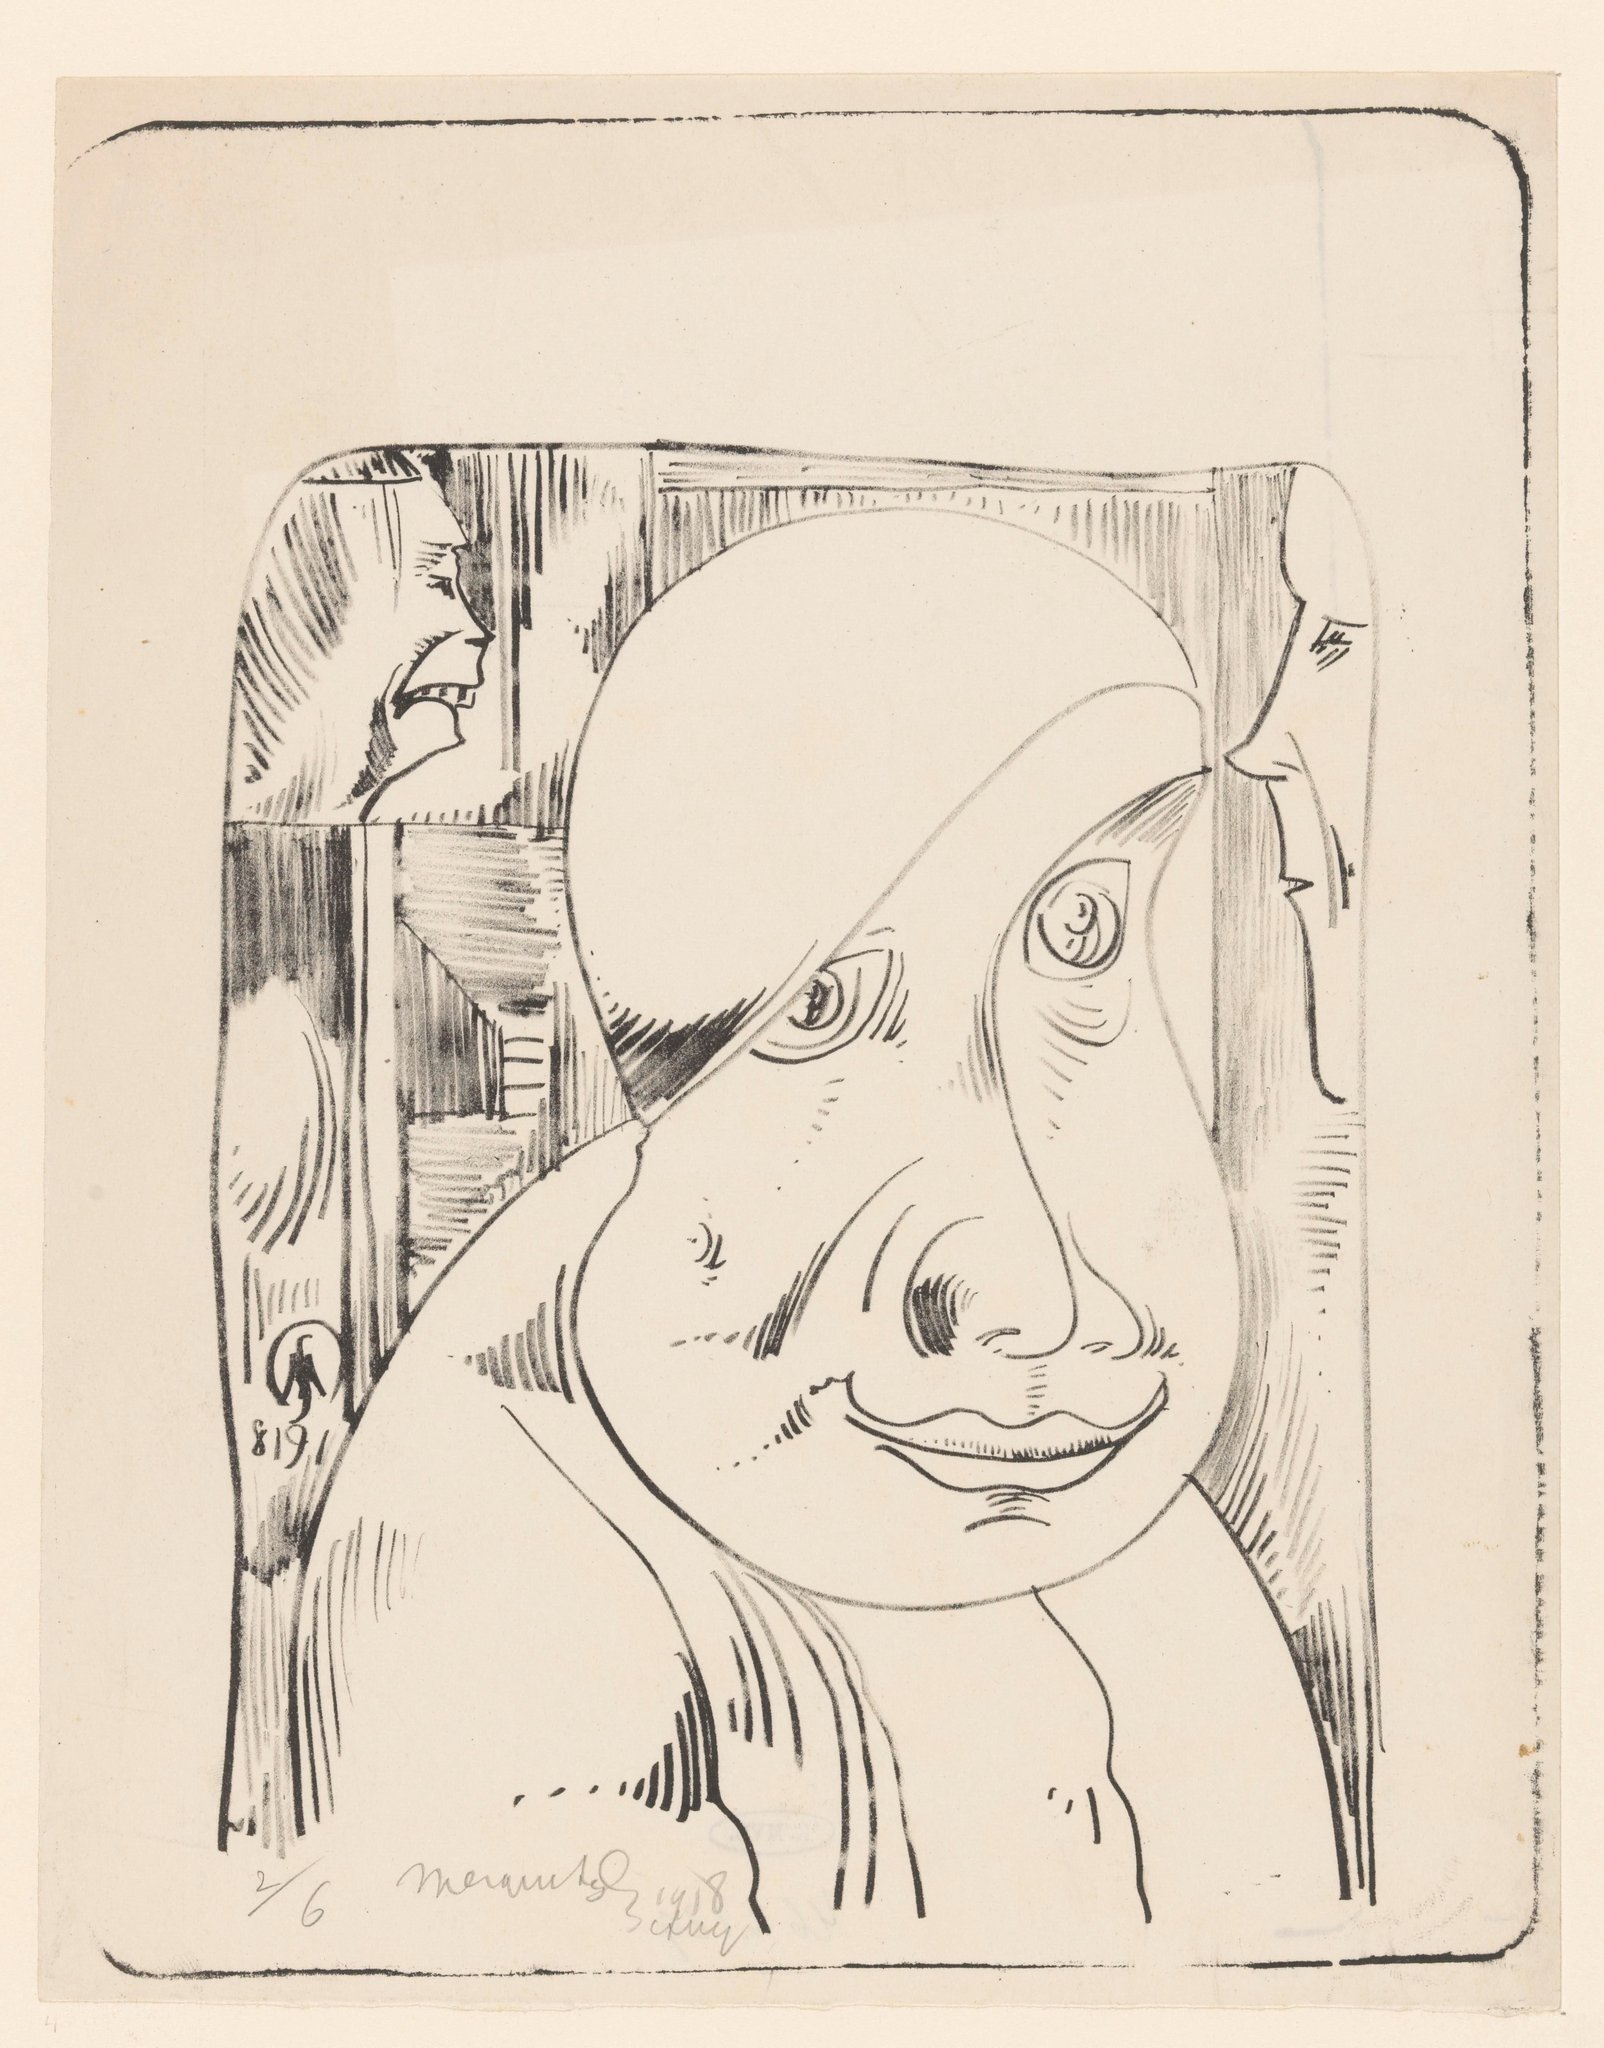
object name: print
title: Fantasie: mannenkop met scheve muts, half over het rechteroog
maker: samuel jessurun de mesquita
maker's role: draughtsman, print maker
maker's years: 1868-1944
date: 1908-1918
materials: paper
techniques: lithograph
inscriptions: signature and date: ‘mesquita 1918/ aug’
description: Mannenkop met scheve muts, half over het rechteroog.